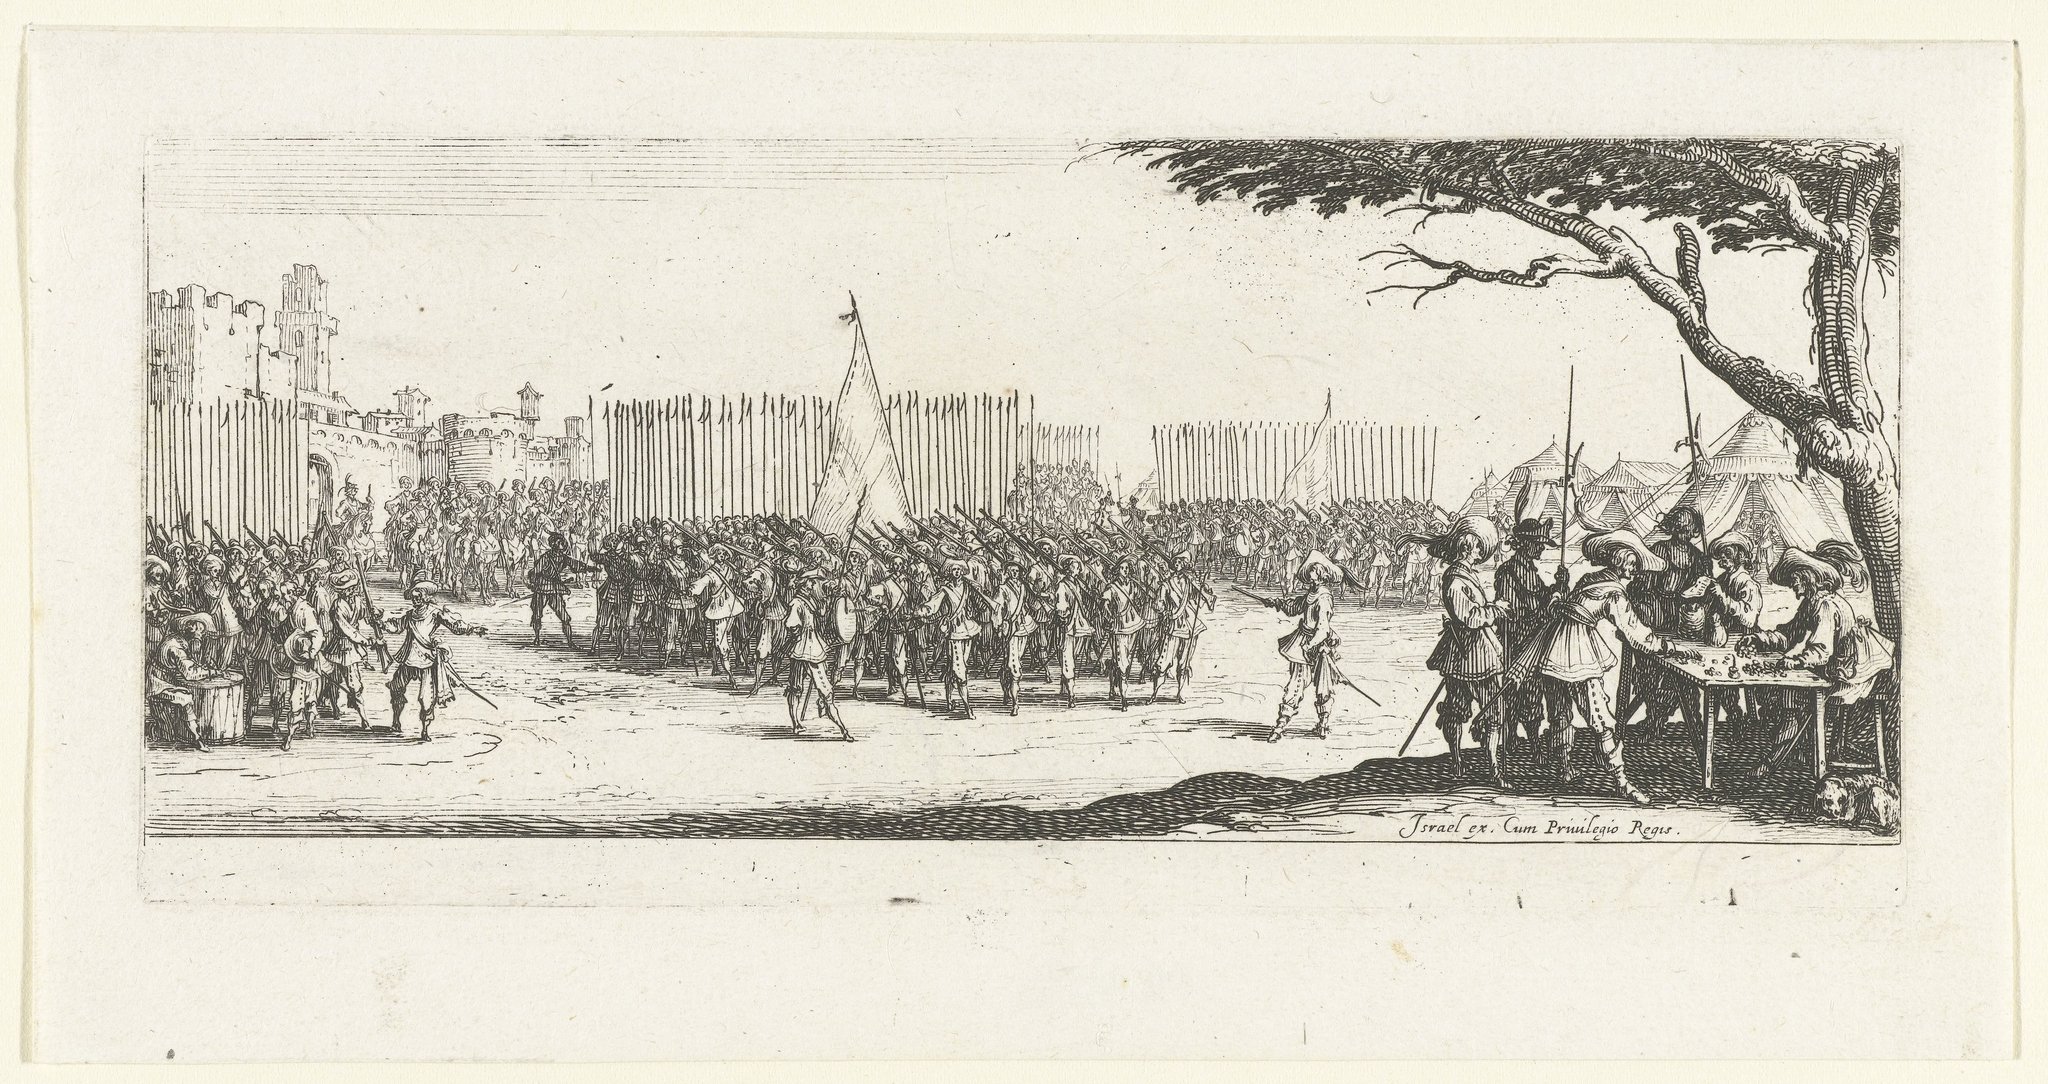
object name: print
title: Recruteren van soldaten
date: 1633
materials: paper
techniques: etching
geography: nancy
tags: recruitment, military training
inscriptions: collector's mark: Lugt 240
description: Links worden recruten ingeschreven en van een wapen voorzien. Rechts wordt hen een bedrag uitbetaald. In het midden en op de achtergrond is te zien hoe zij getraind worden. Links op de achtergrond de muren van een stad. Onder de voorstelling een lege marge. Deze prent is onderdeel van een serie van 17 (18 incl. titelprent) prenten met voorstellingen van diverse soorten ellende die oorlogvoering met zich meebrengt.